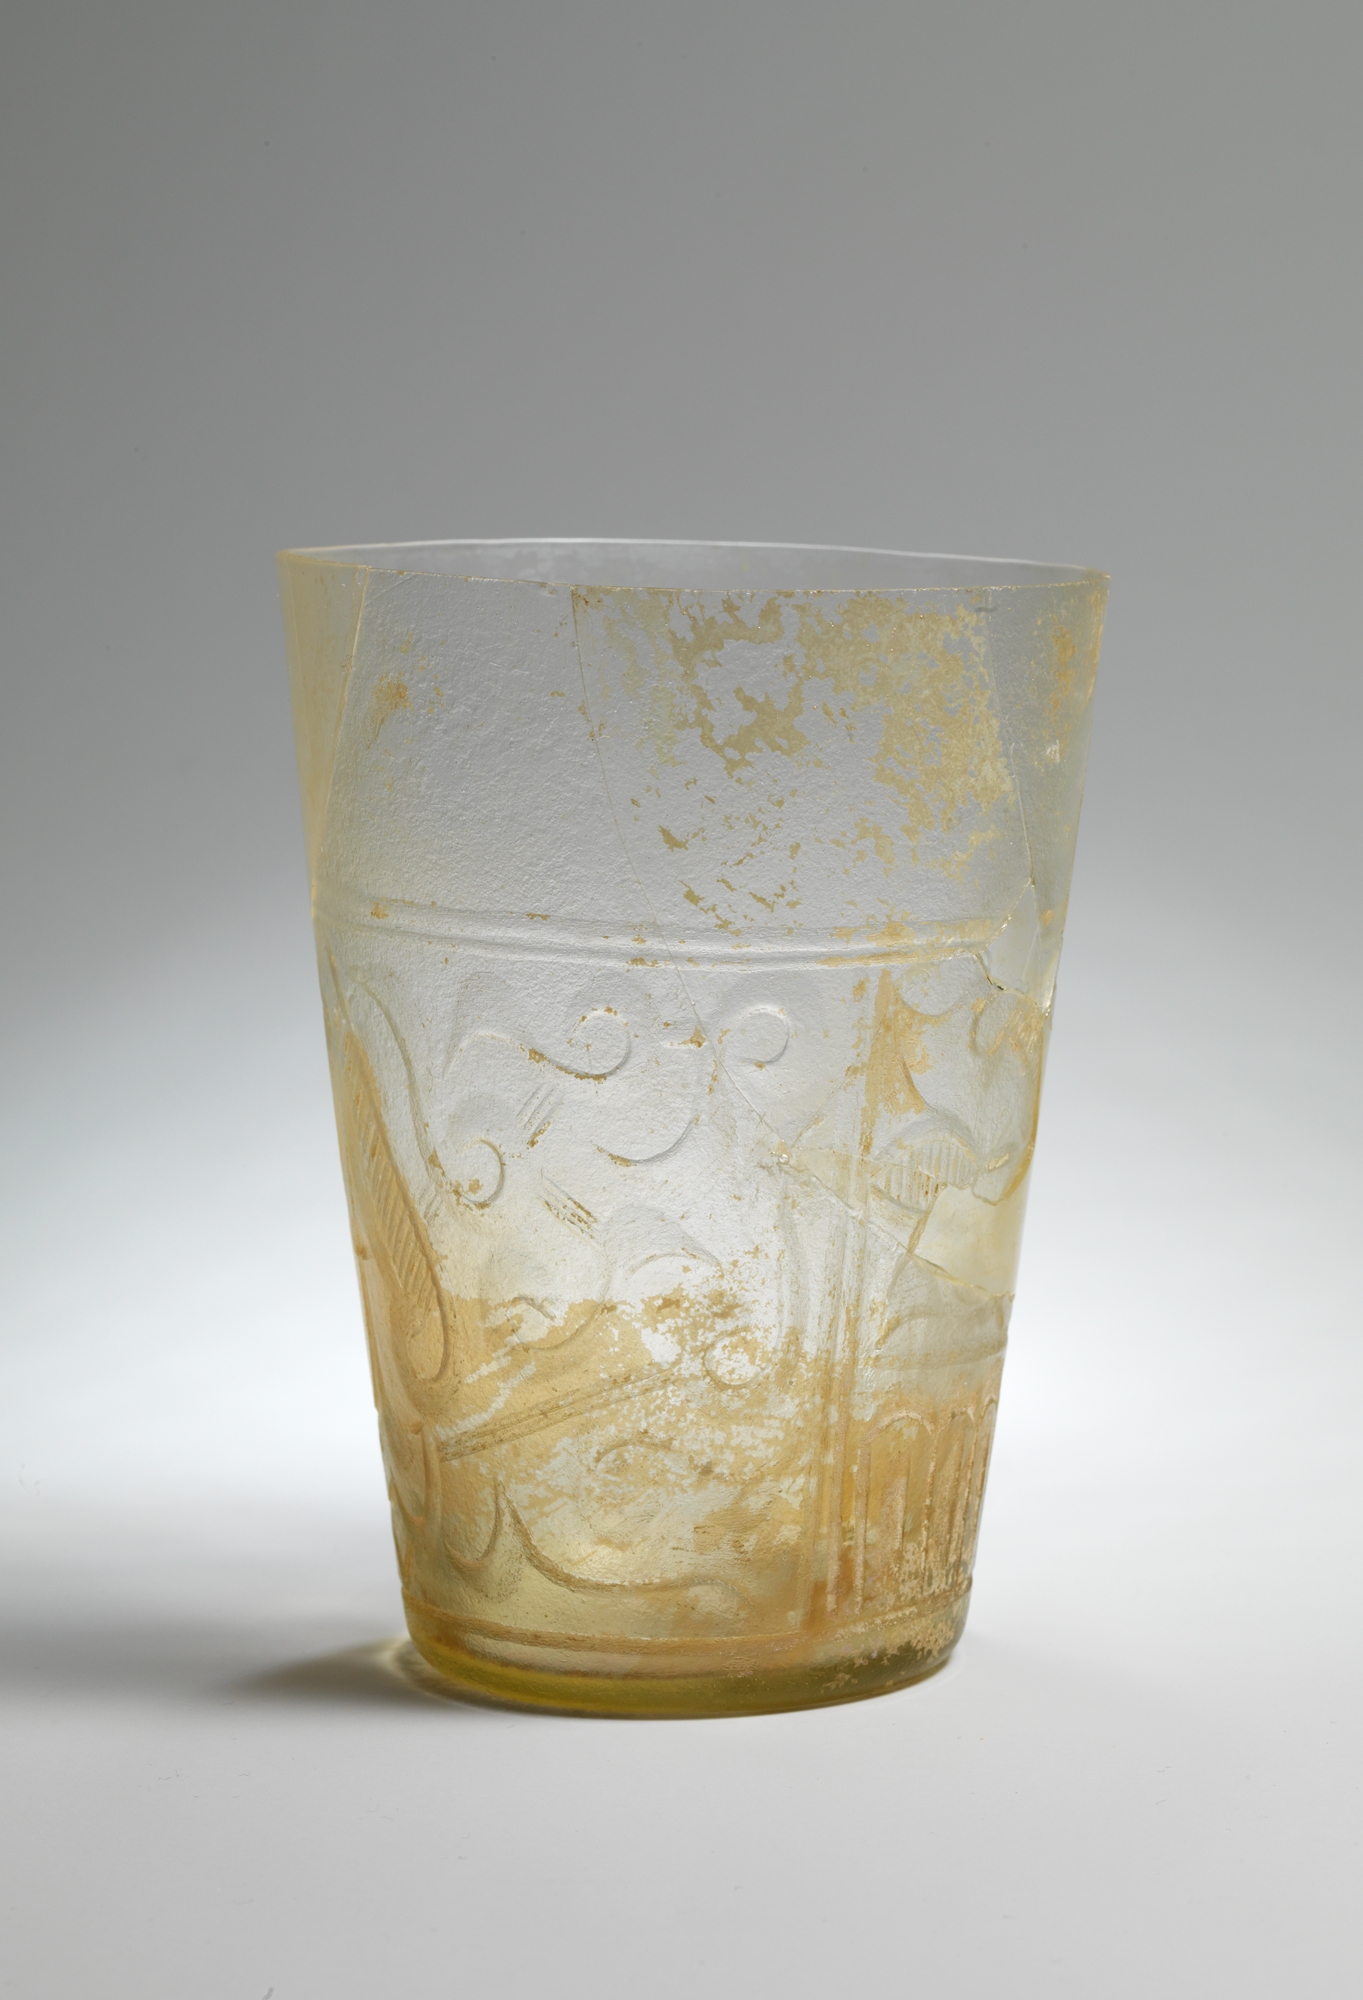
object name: beaker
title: Beaker with Relief Decoration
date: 901-1000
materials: glass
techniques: glassblowing, cutting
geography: iran